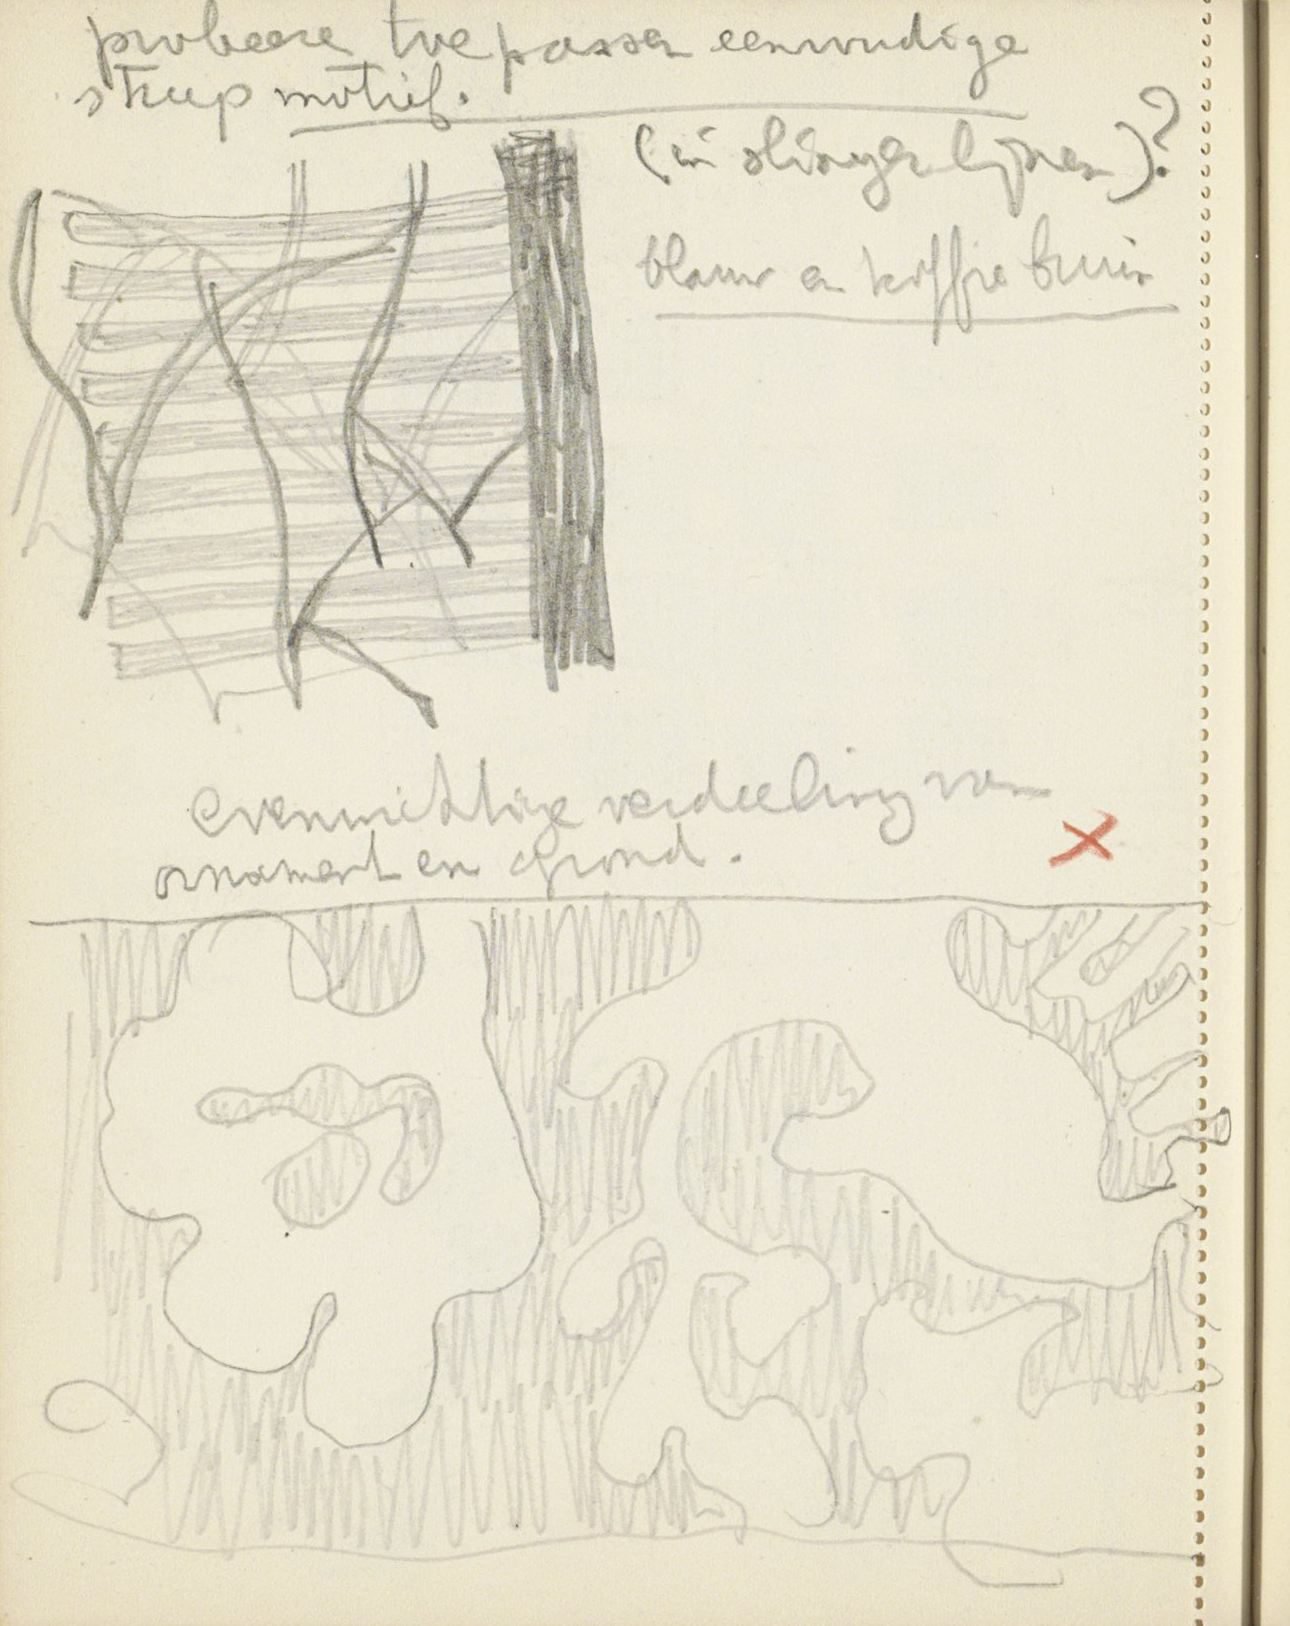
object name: sketchbook leaf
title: Decoratieve patronen met lijnen en ornamenten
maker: reijer stolk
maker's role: draughtsman, print maker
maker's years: 1896-1945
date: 1916-1945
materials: paper, pencil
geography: africa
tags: ornaments ~ art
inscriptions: annotation: ‘probeer toepassen eenvoudige/ streep motief/ (in slingerlijnen)?/ blauw en koffiebruin/ evenwichtige verdeeling van/ ornament en grond.’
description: Blad 38 verso uit een schetsboek met 60 bladen.